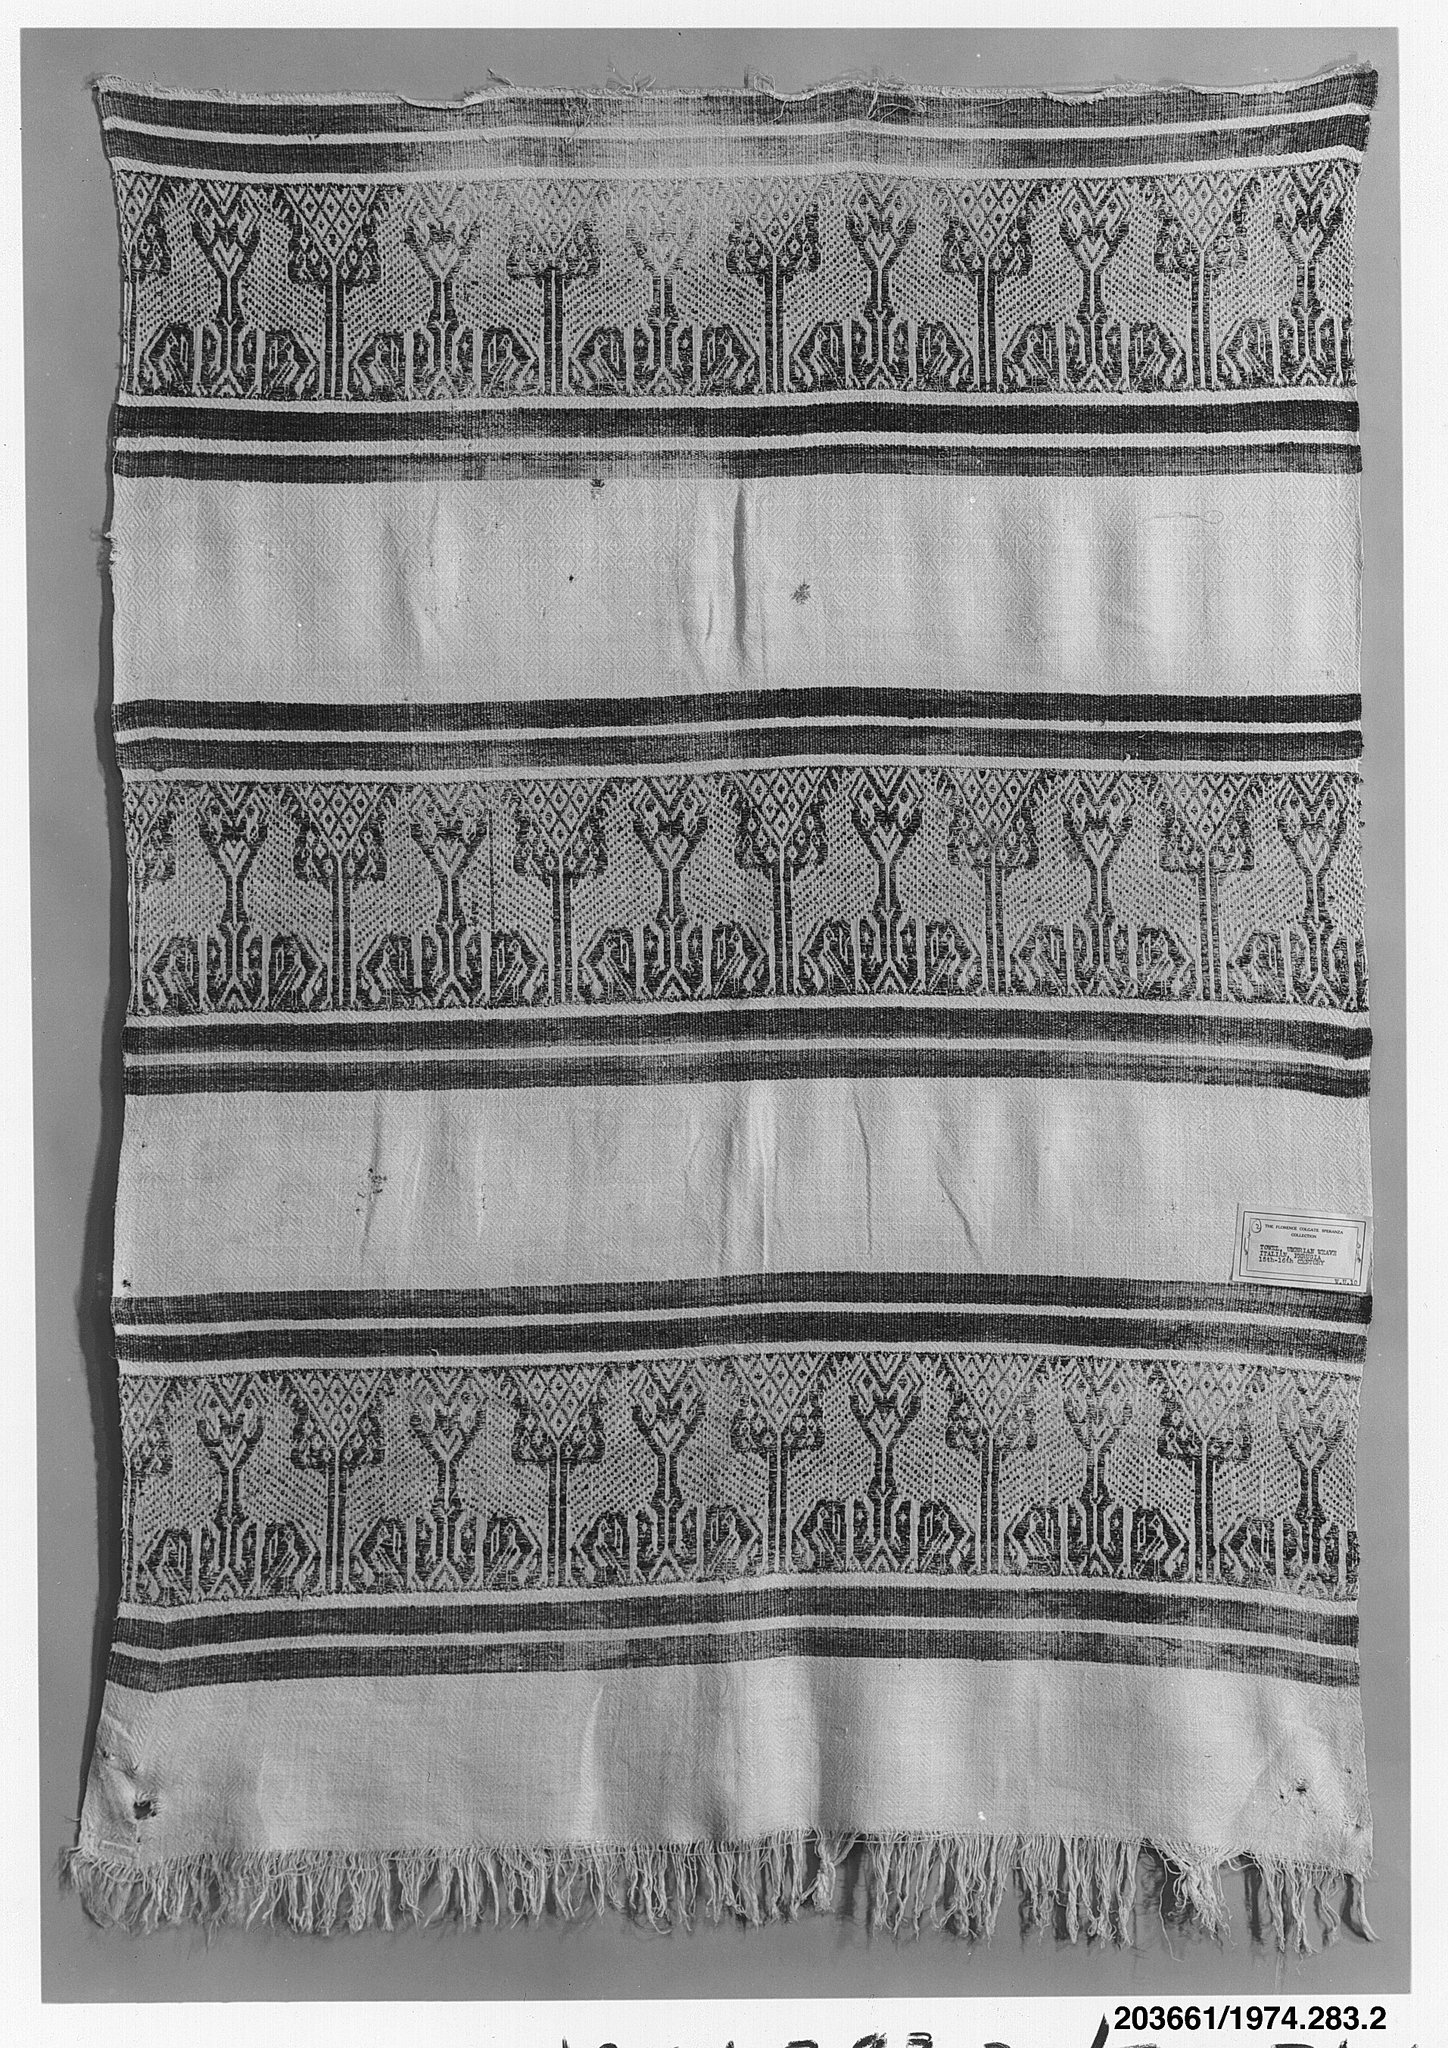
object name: towel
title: Towels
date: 1401-1600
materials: cotton, linen